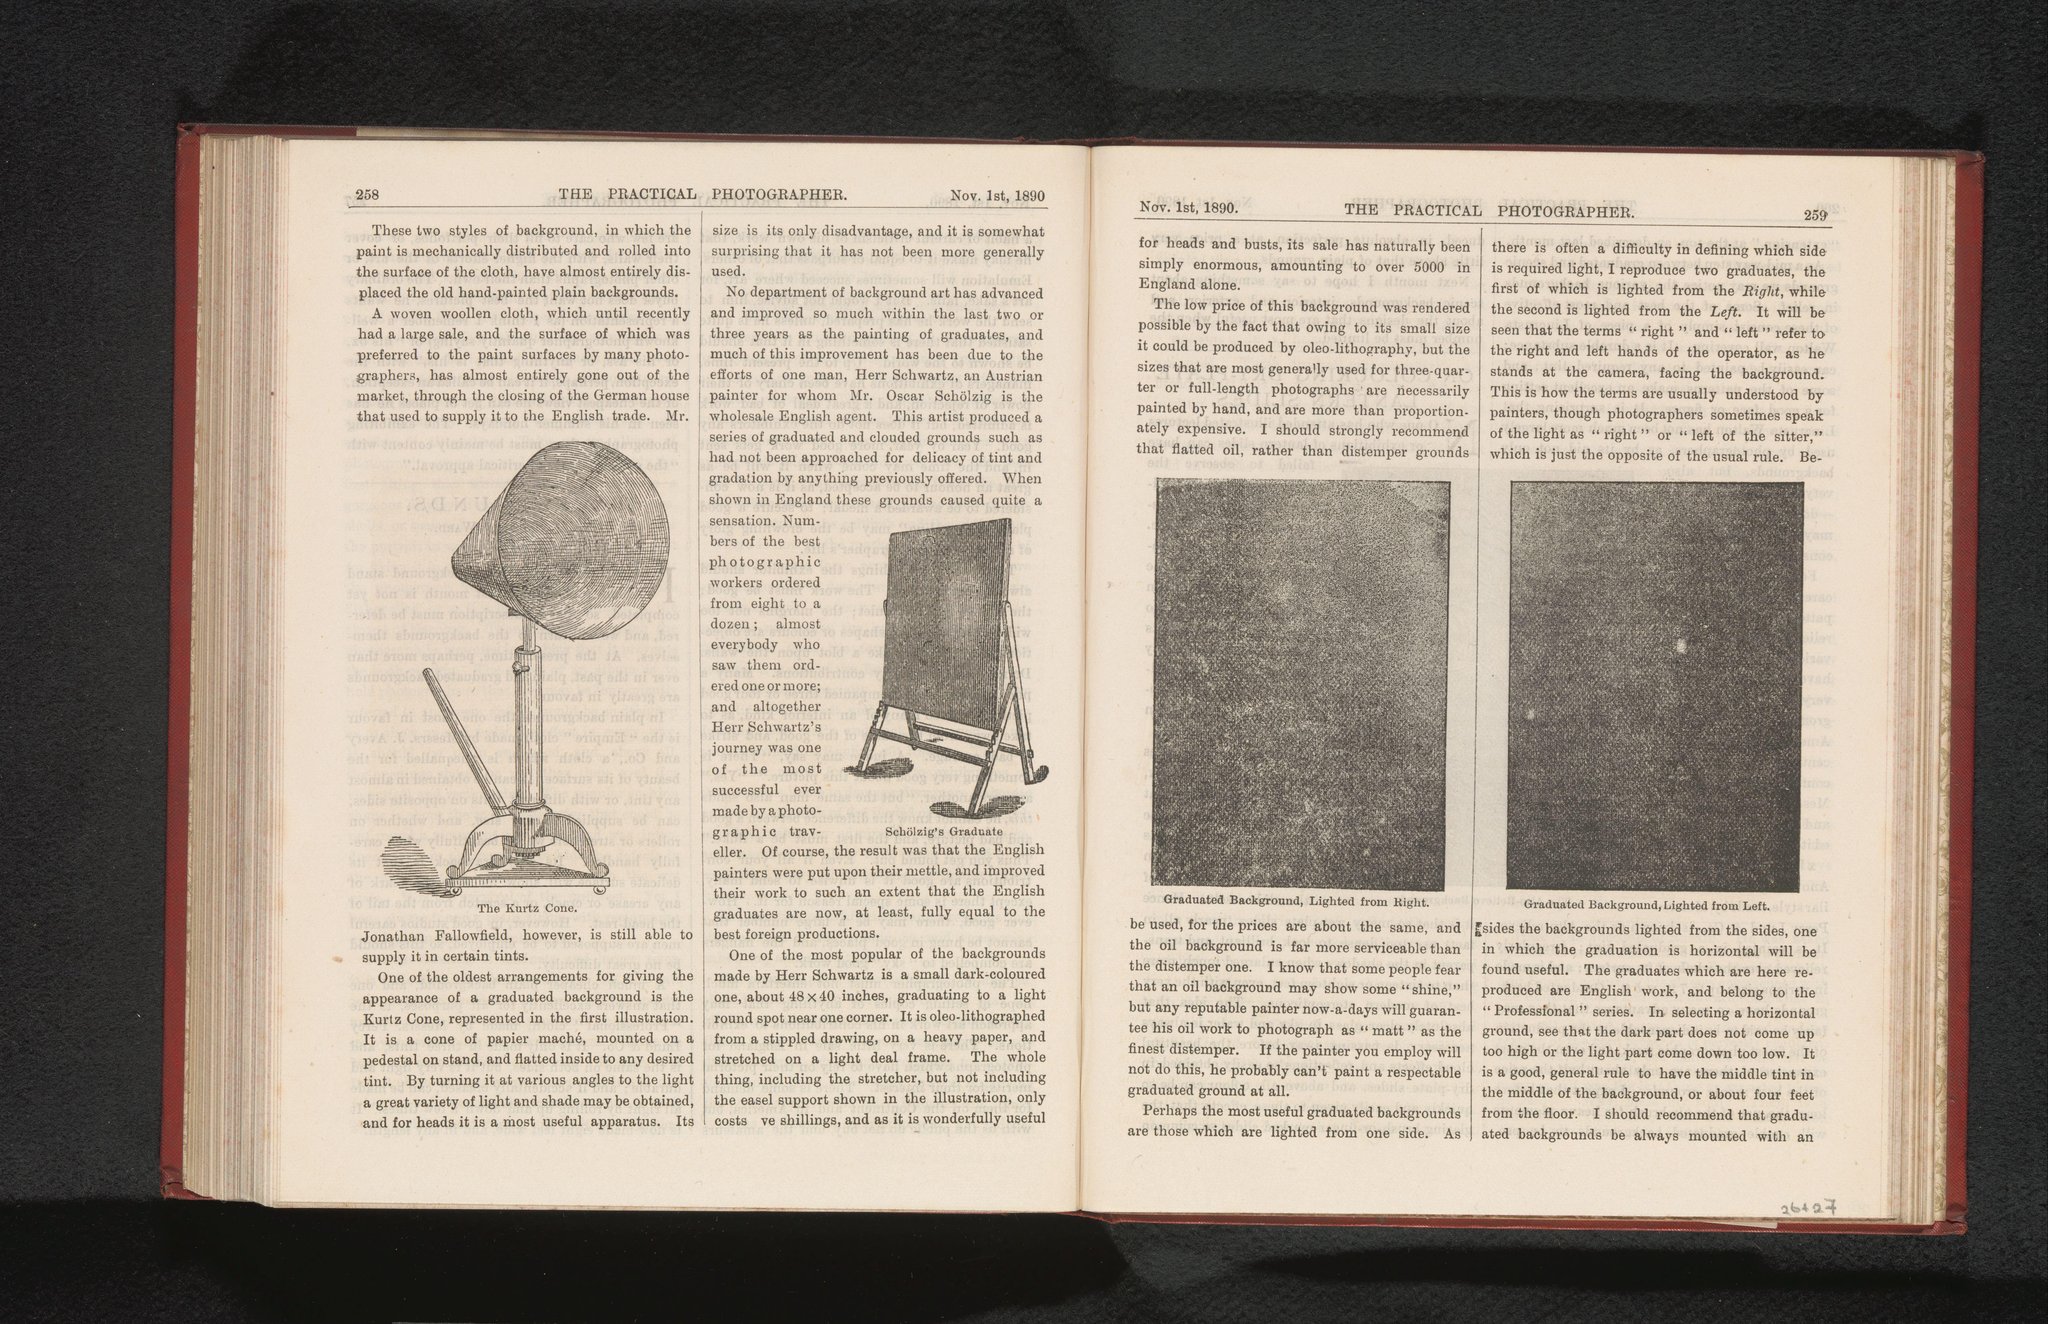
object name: photomechanical print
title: Voorbeeld van een achtergrond, van links belicht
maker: Anonymous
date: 1885-1890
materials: paper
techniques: autotype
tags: photography